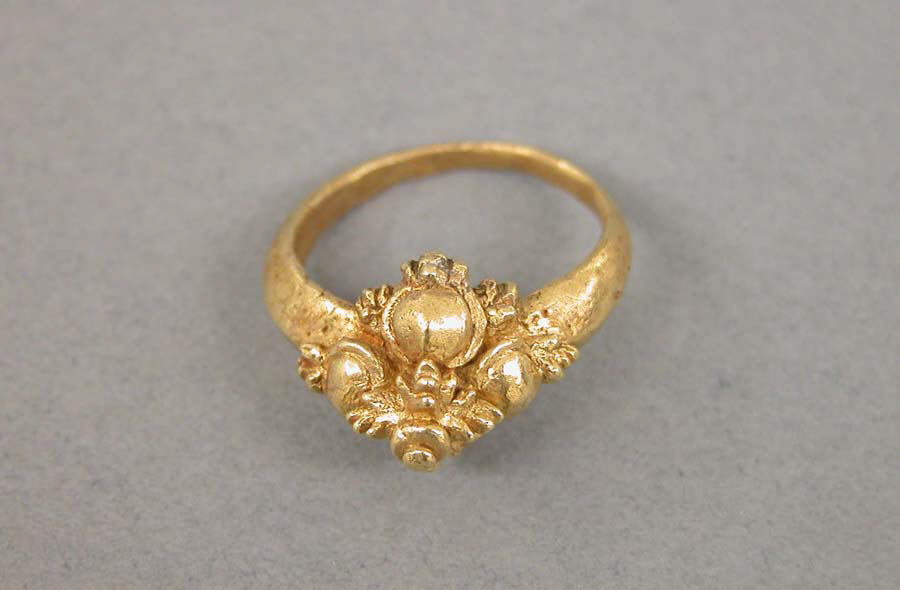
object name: ring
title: Ring with Raised Quatrefoil Design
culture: indonesian, javanese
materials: gold